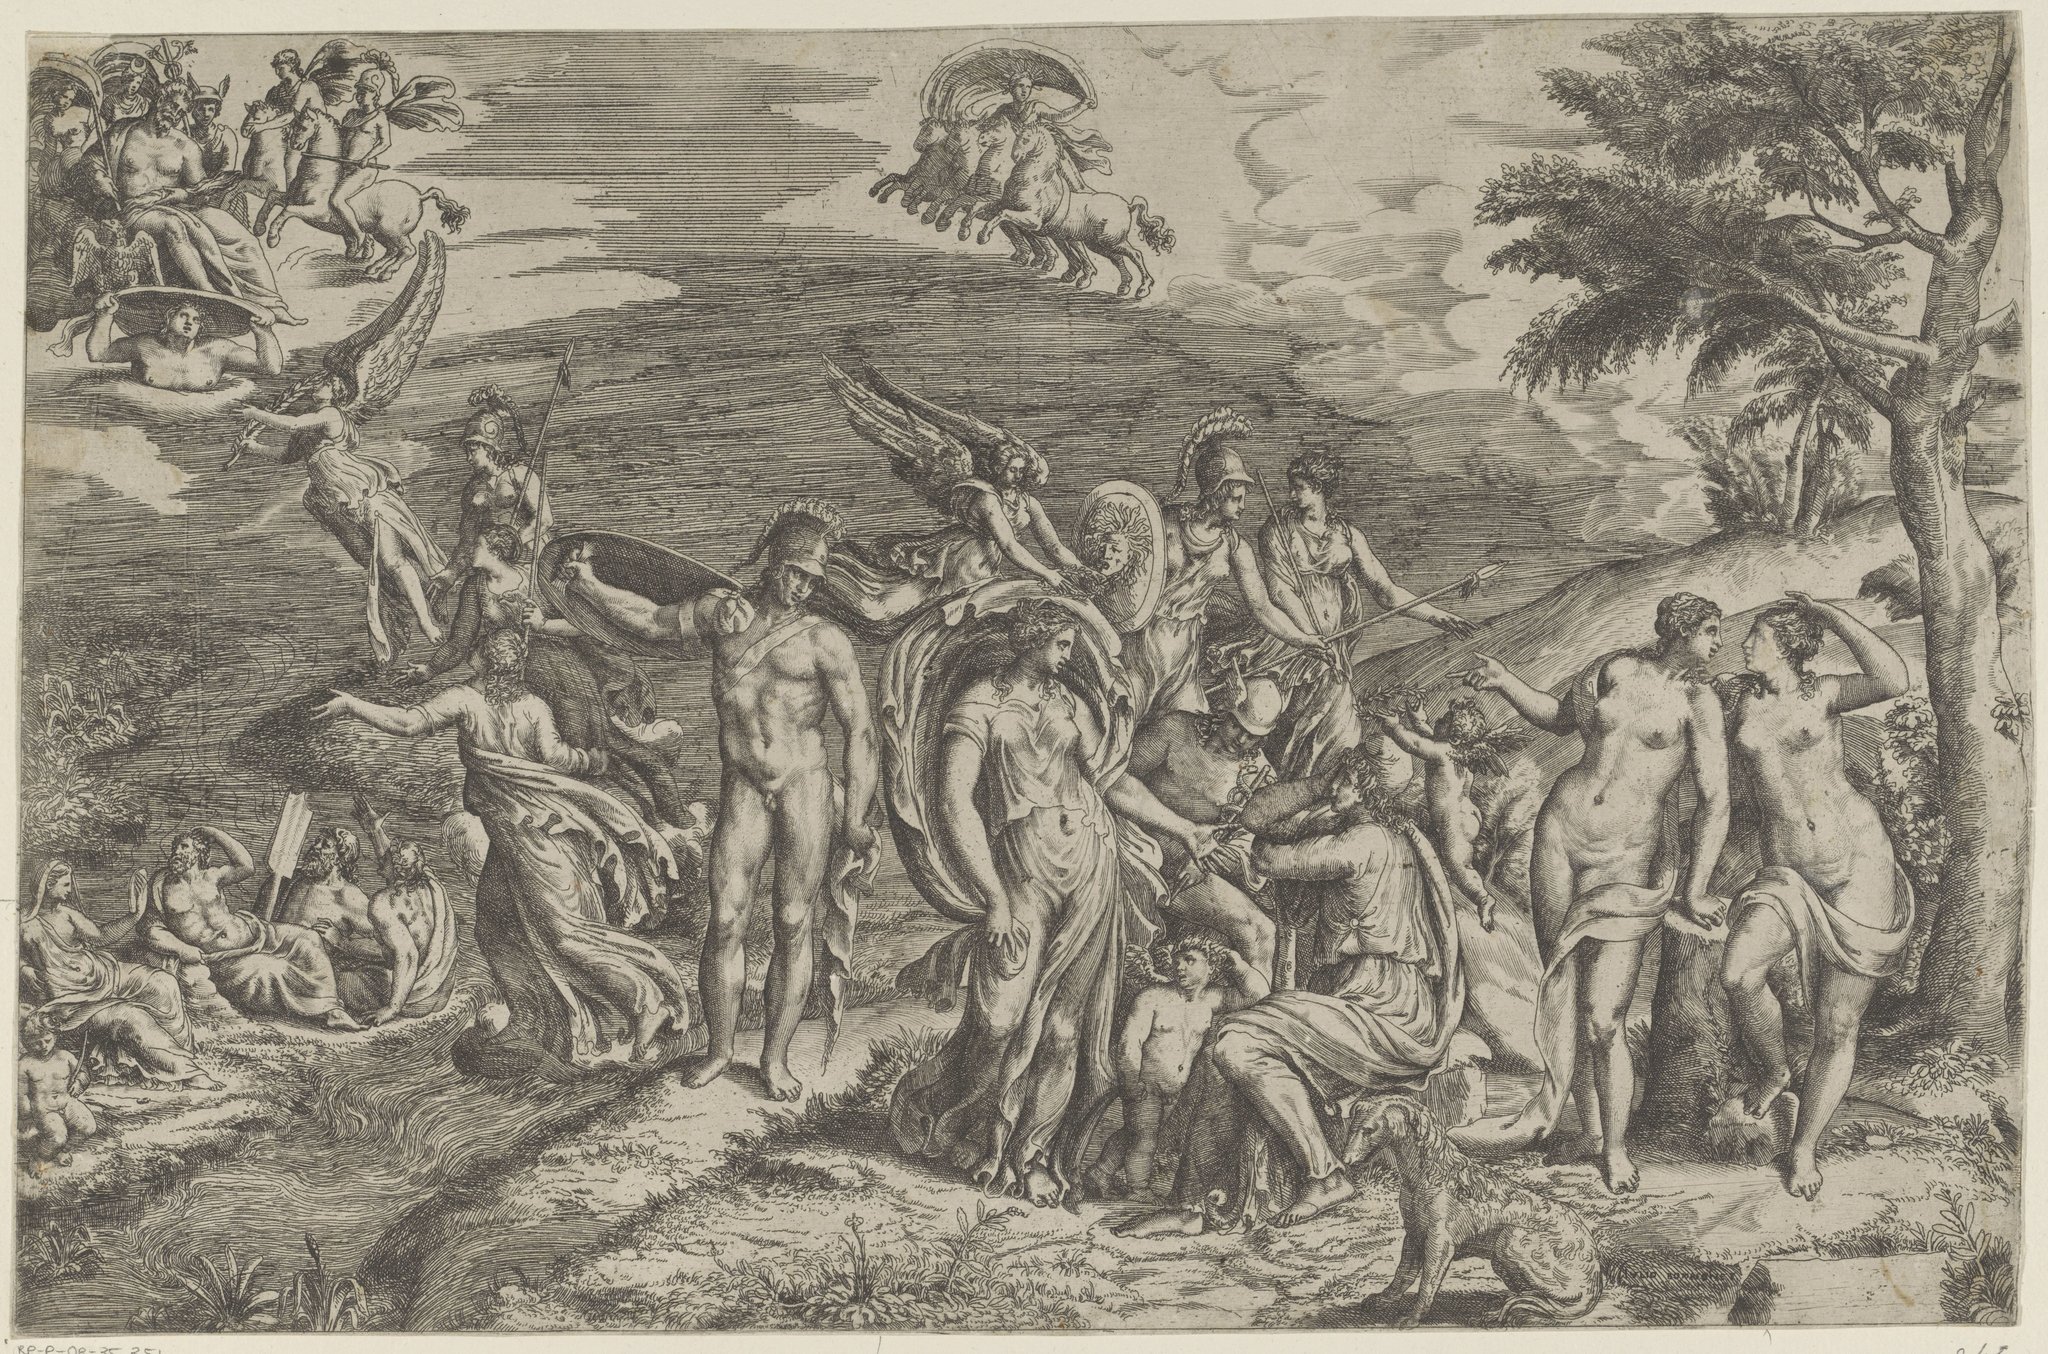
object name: print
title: Het oordeel van Paris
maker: giulio bonasone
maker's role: painter, print maker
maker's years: 1510-1576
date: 1501-1580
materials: paper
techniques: engraving, etching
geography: italy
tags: the judgement of paris (mercury present), male roman deities, apollo in the chariot of the sun, drawn by four horses, usually preceded by aurora holding a torch; 'carro del sole' (ripa), female roman deities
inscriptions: collector's mark: Lugt 240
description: Rechts vind het oordeel van Paris plaats, waarbij de zittende Paris zijn keuze maakt voor Venus. Achter hem staan Mercurius, Juno en Minerva. Uiterst rechts staan twee naakte vrouwen (mogelijk nimfen). Centraal staat Mars met helm en schild. Midden boven vliegt Apollo op zijn zonnewagen. Linksboven en onder zitten verschillende goden, onder wie Jupiter en Diana.